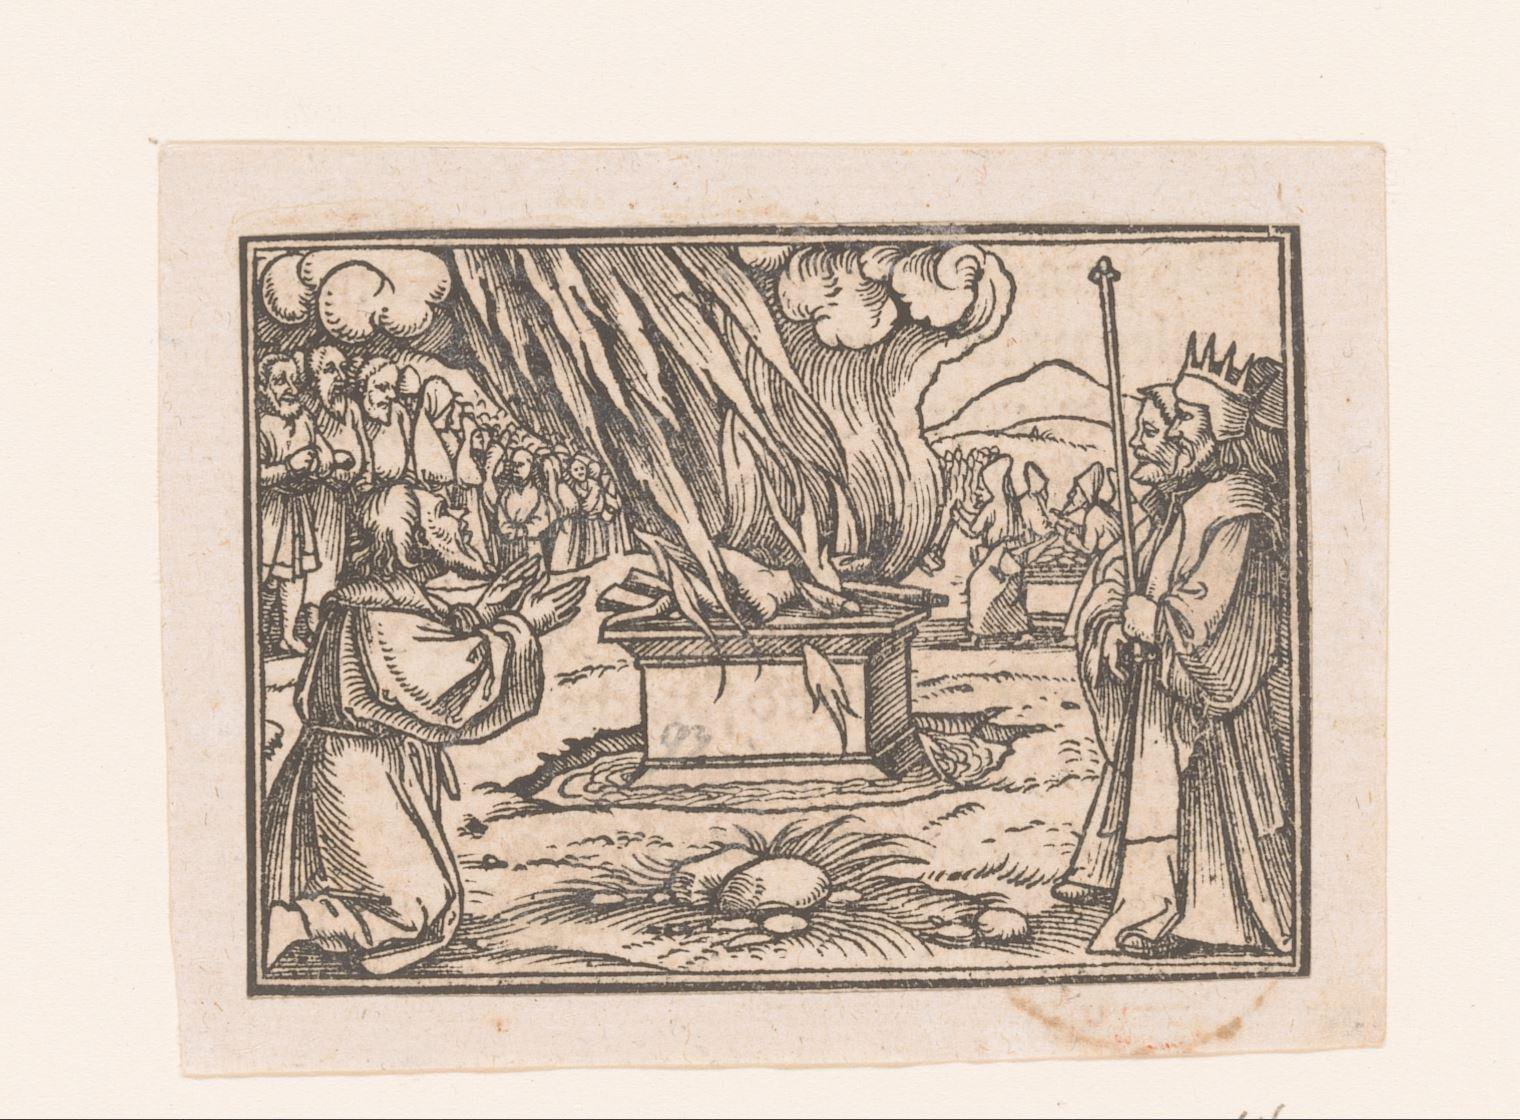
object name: print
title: Kopieën naar Holbein's bijbelillustraties voor de Biblia Utriusque Testamenti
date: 1552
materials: paper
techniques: woodcut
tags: story of elisha (eliseus)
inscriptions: collector's mark: Lugt 240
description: Gespiegelde kopie van een houtsnede van Hans Holbein de jongere uit 1526. Origineel voor het eerst als boekillustratie gebruikt in: Biblia Utriusque Testamenti iuxta Vulgatam Translationem, Lyon, M. en G. Trechsel (voor Hugo à Porta) 1538. Deze kopie gemaakt voor: Biblia sacra iuxta vulgatam. Parijs: Jean Benoît, 1552.